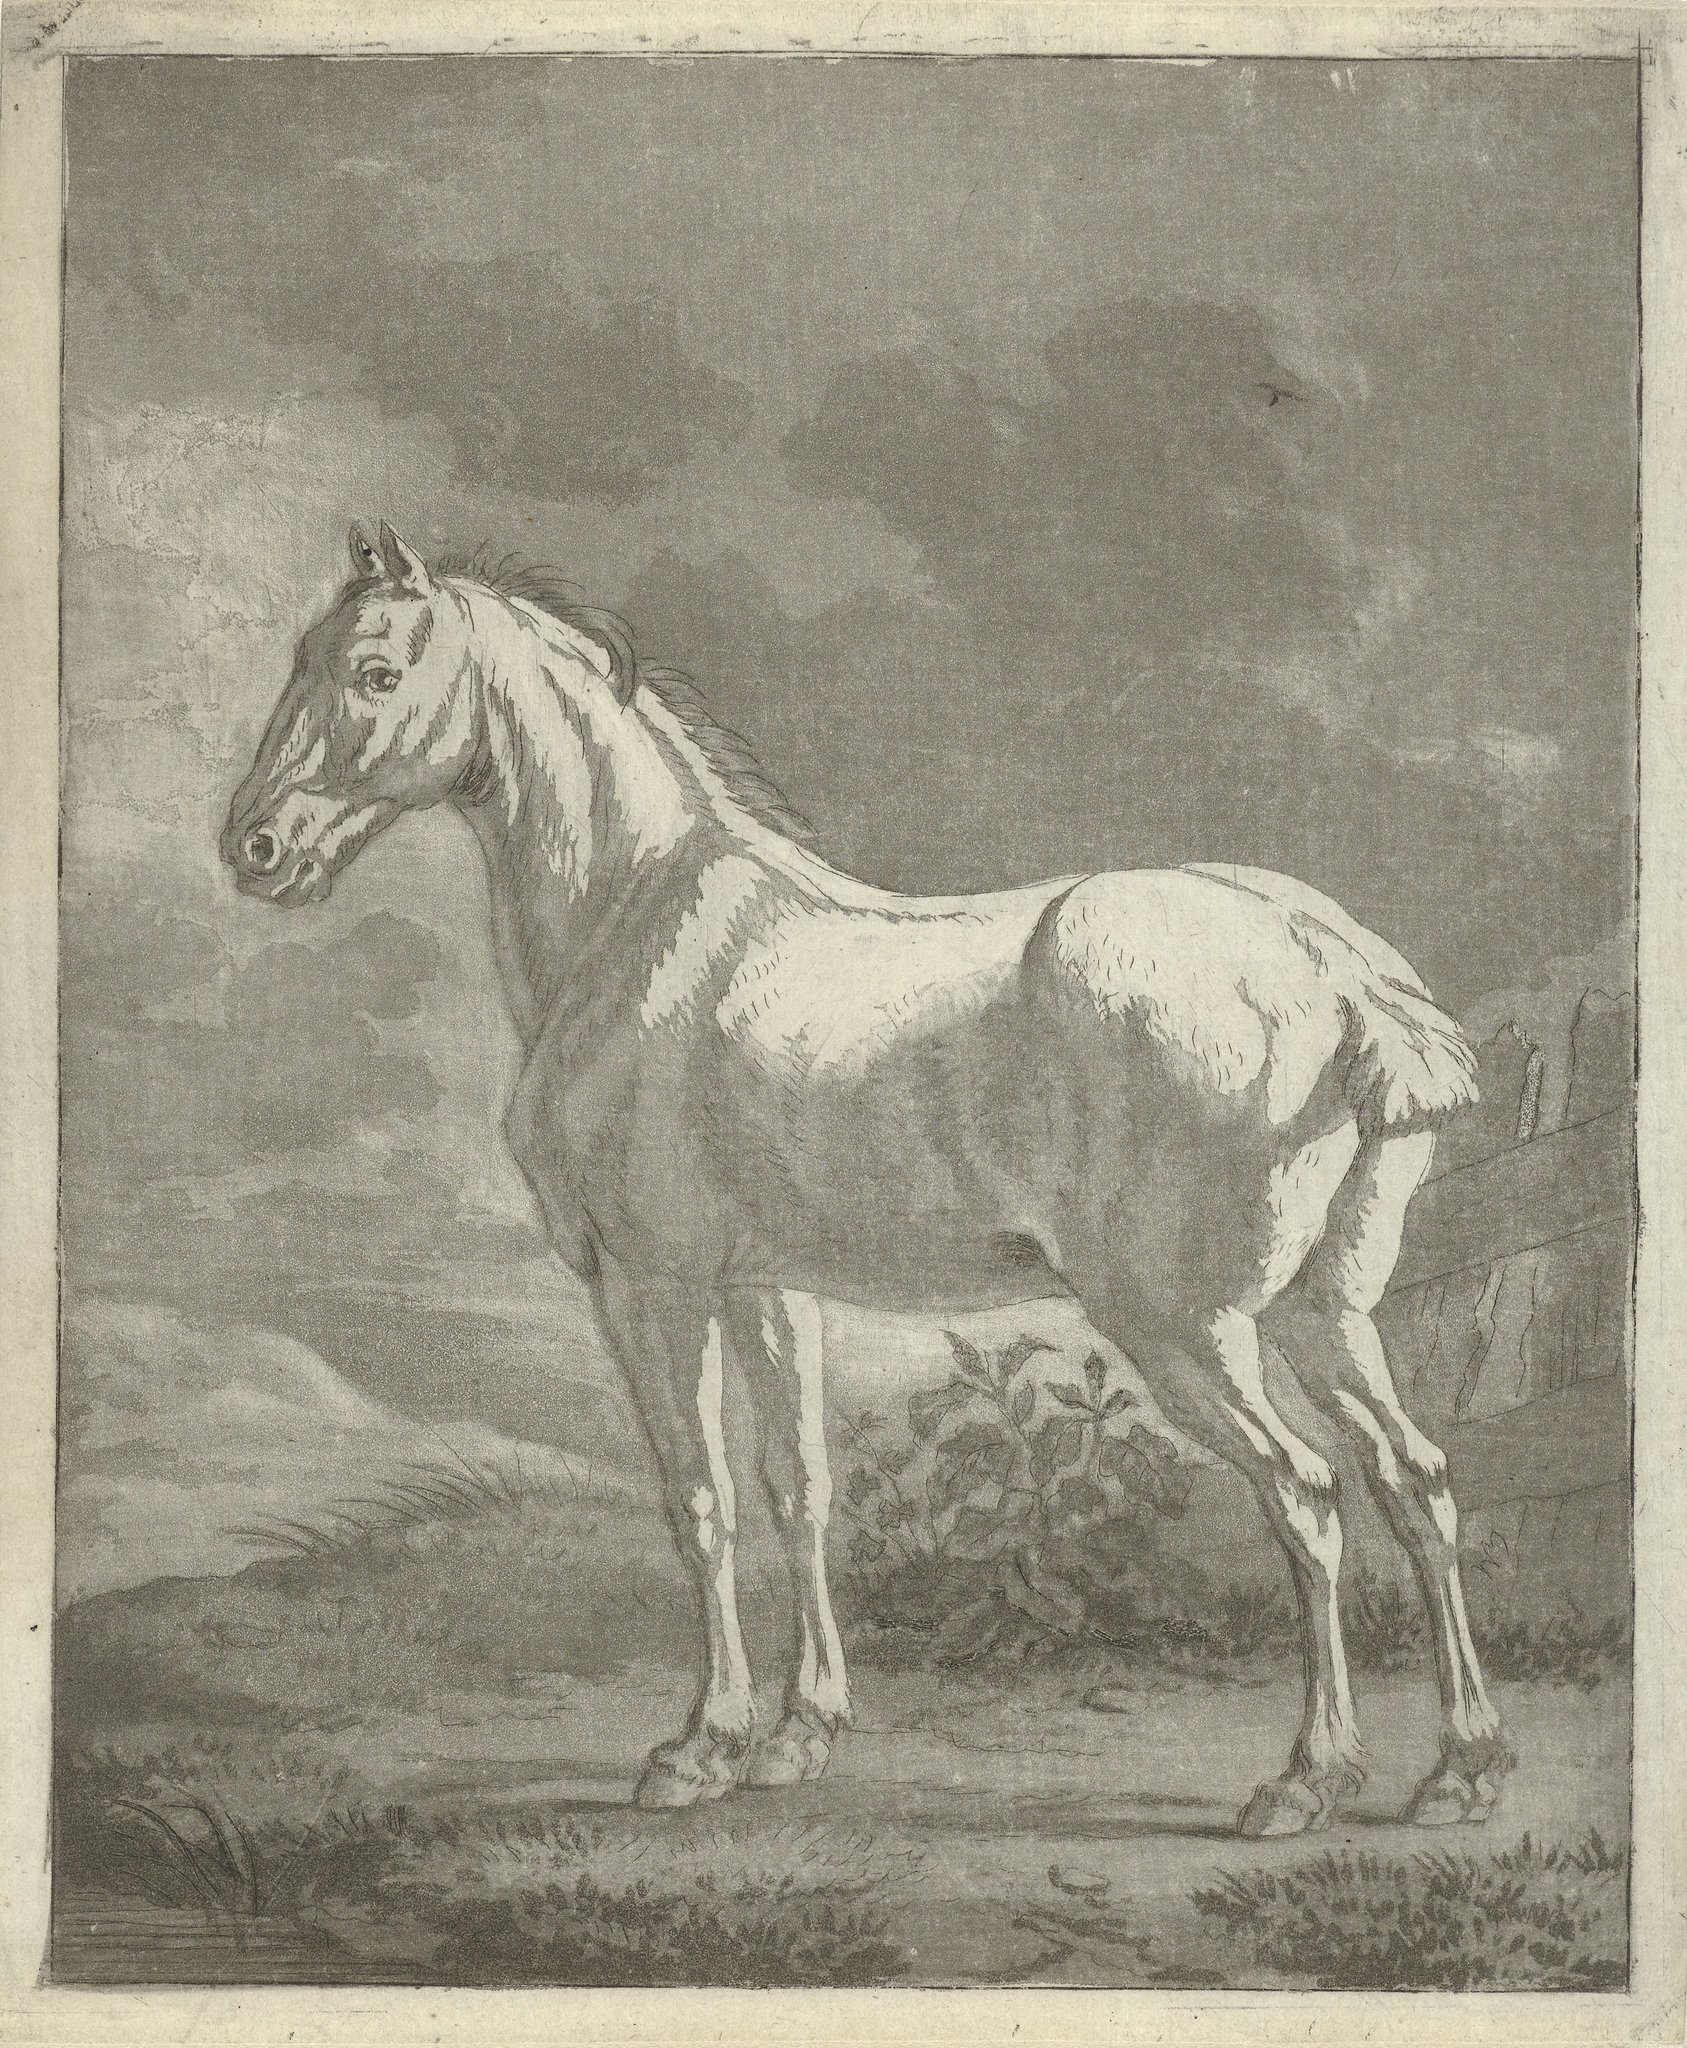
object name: print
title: Schimmel in een wei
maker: tethart philip christian haag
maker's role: draughtsman, print maker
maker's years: 1737-1812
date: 1747-1812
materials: paper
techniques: aquatint, etching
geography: the hague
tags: horse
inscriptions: collector's mark: Lugt 2228